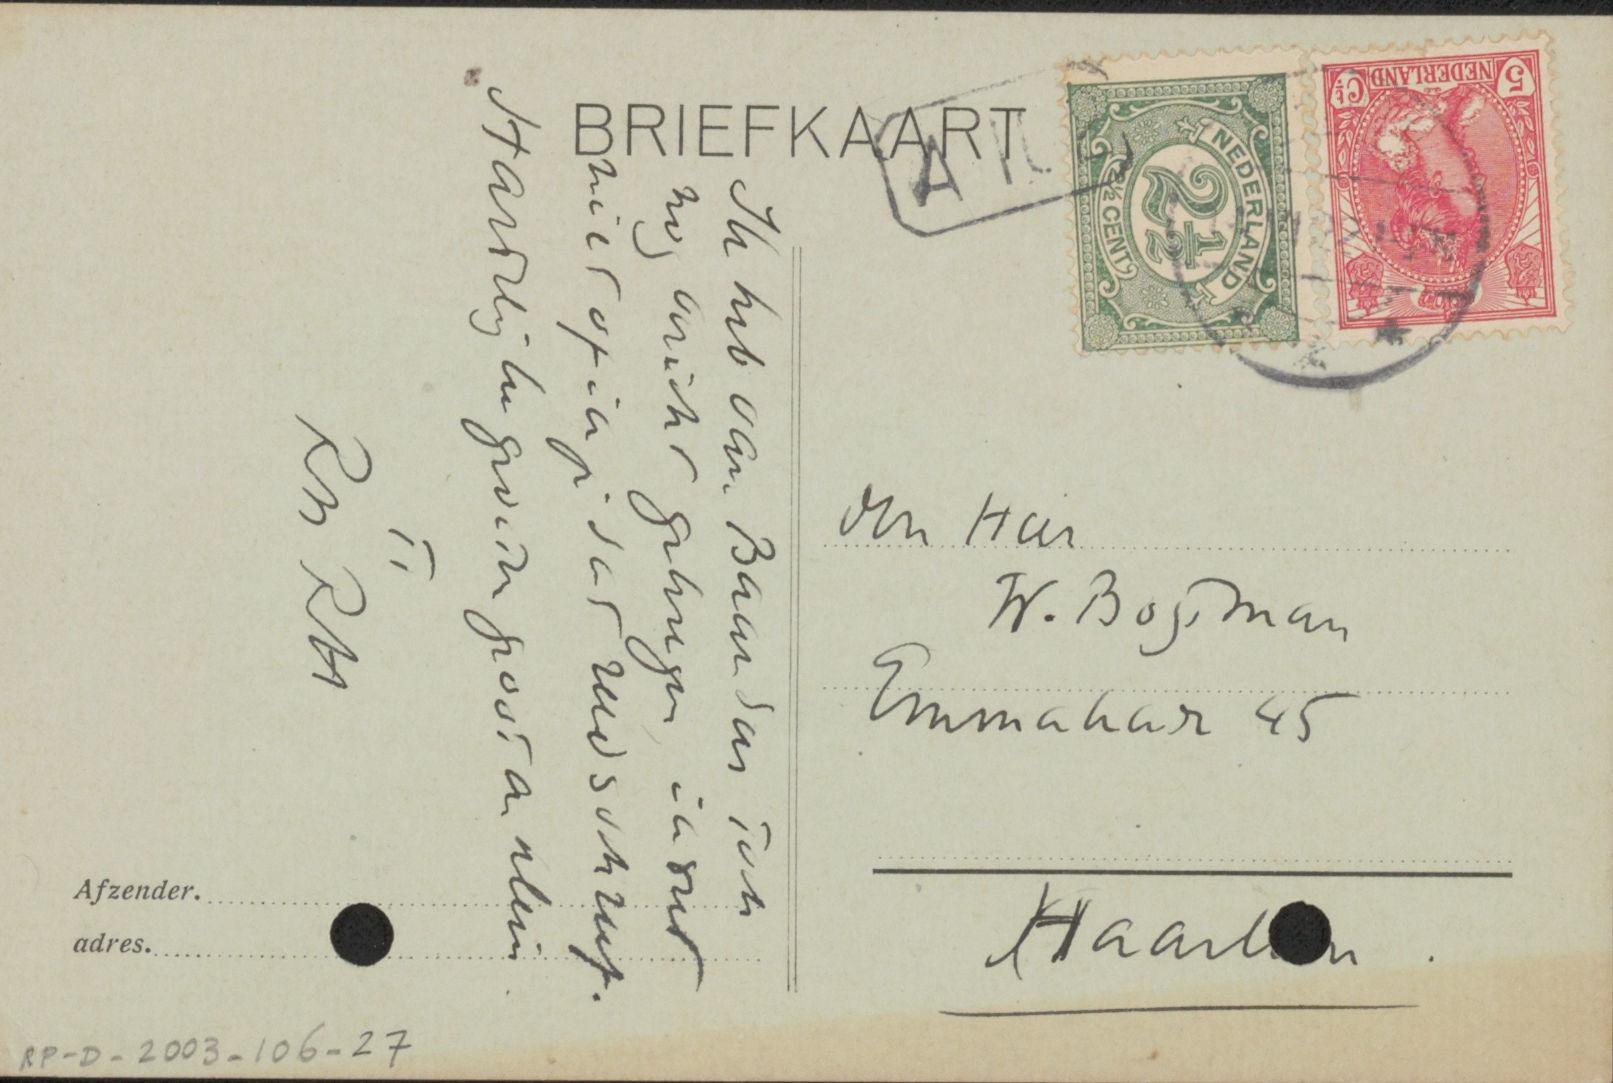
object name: postcard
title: Briefkaart aan Willem Bogtman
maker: richard nicolaüs roland holst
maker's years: 1868-1938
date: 1922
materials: cardboard, ink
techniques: pen, writing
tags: haarlem, willem bogtman, amsterdam, herman ambrosius jan baanders, drawing, applied arts, arts and crafts; industrial design